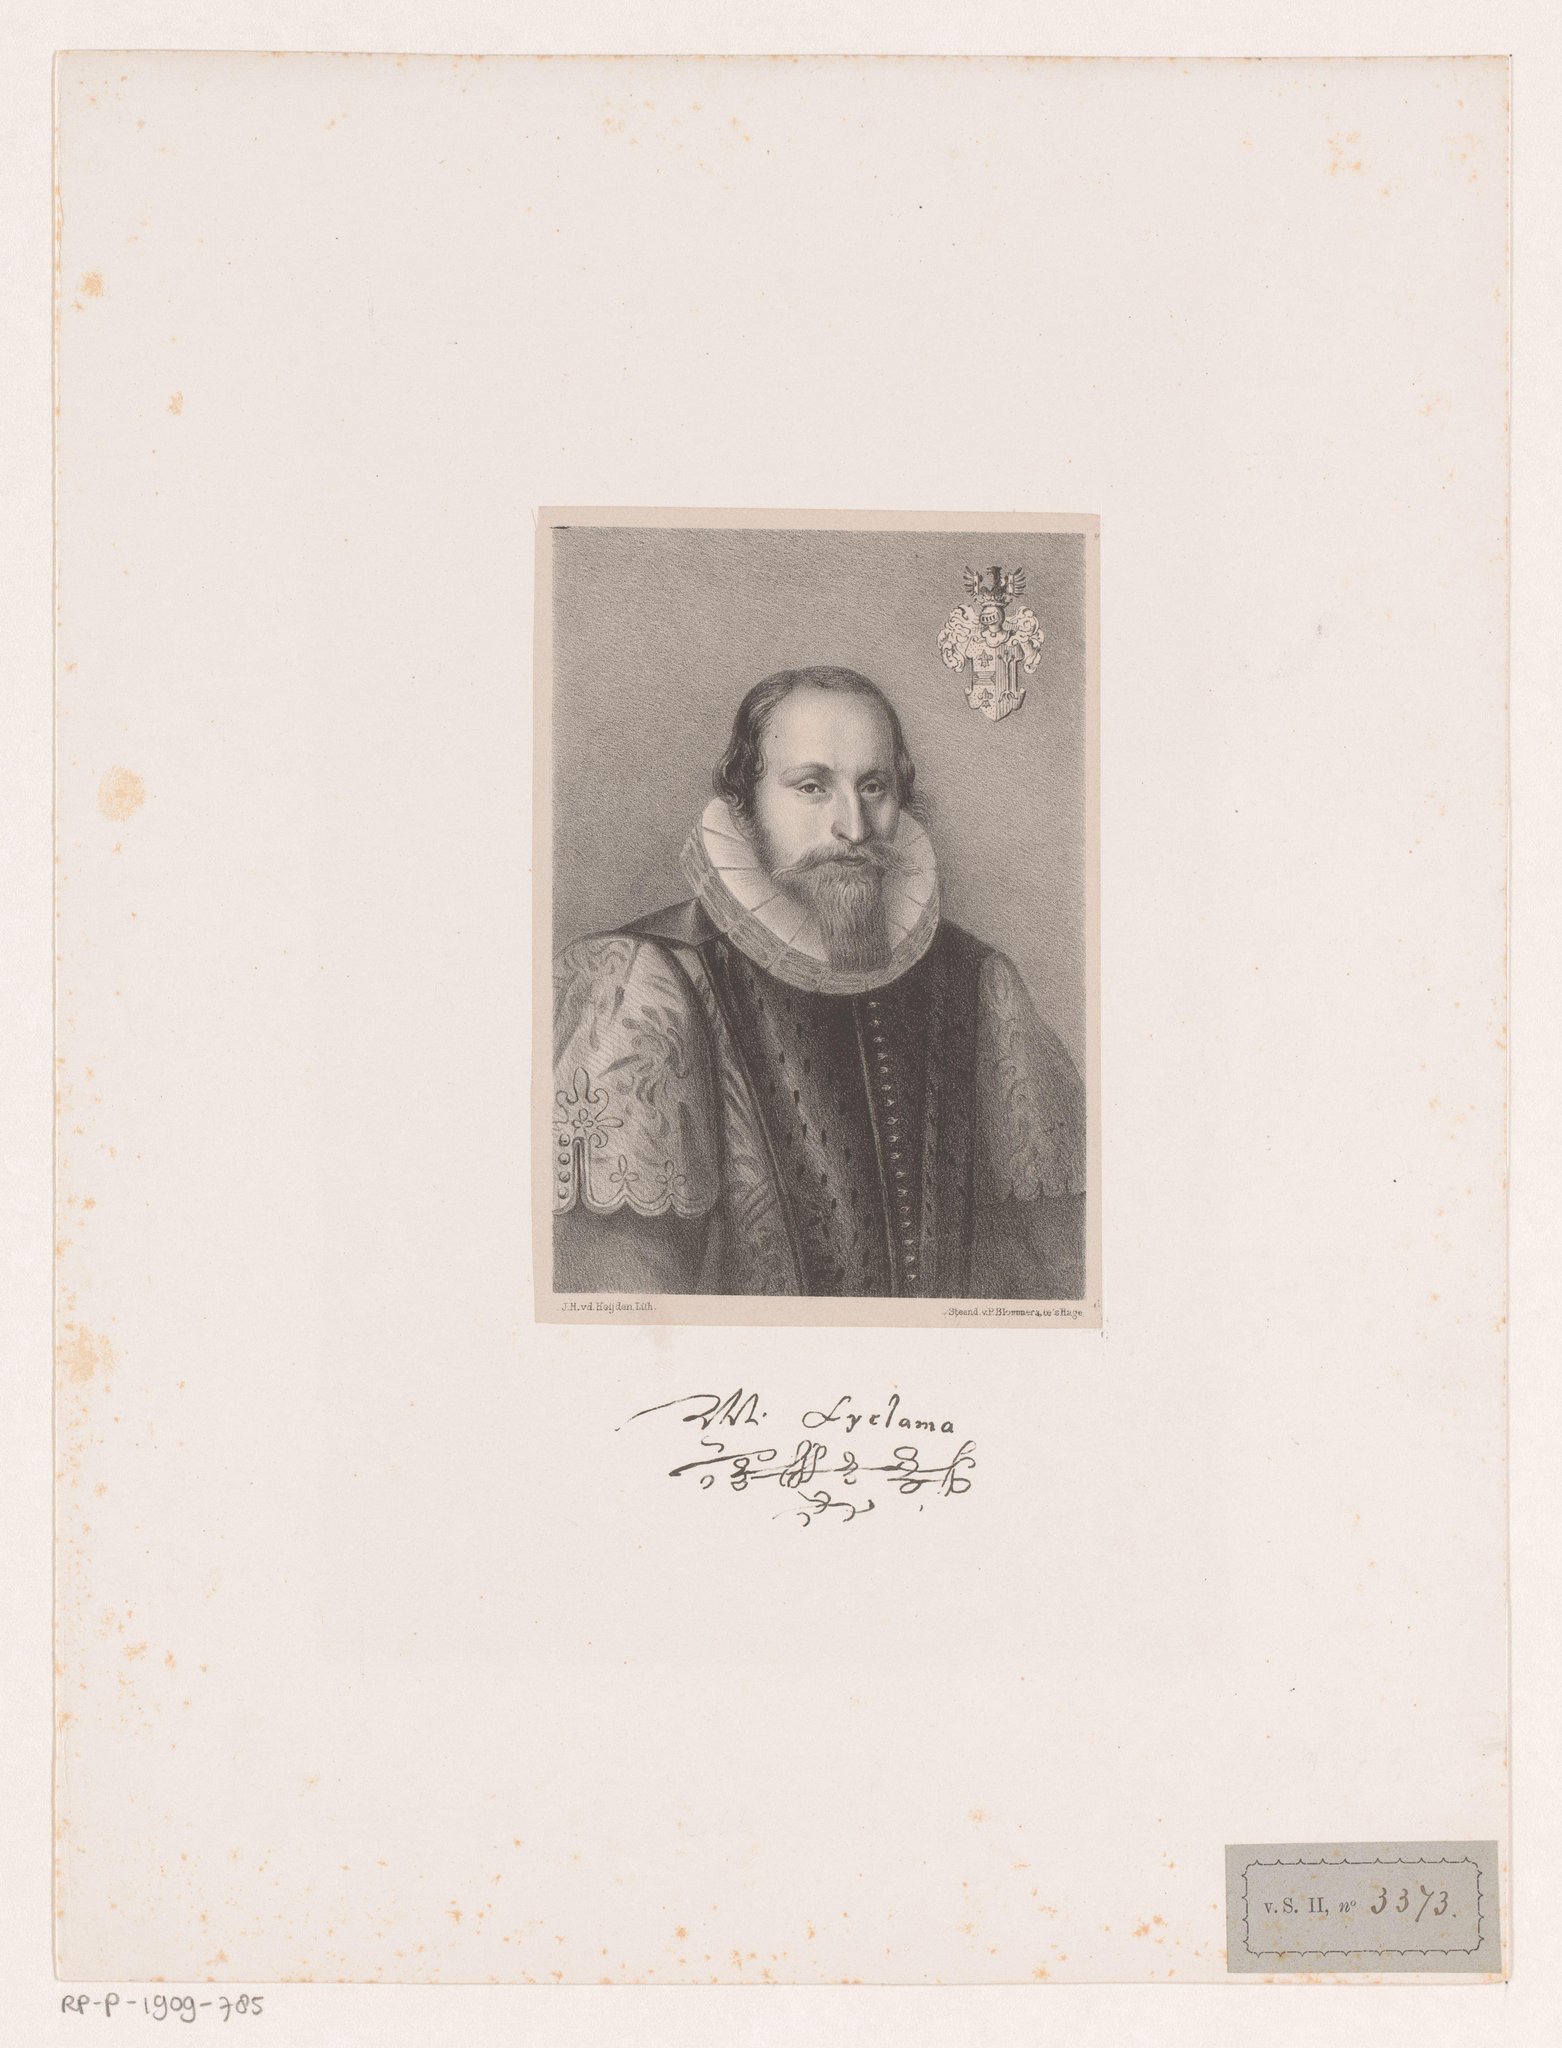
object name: print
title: Portret van Marcus Lyclama a Nyeholt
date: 1842-1887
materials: paper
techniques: lithograph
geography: the hague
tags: neck-gear ~ clothing (with name), historical persons (+ (full) bust portrait), armorial bearing, heraldry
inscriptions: collector's mark: Lugt 2228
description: De geportretteerde heeft een baard, sik, snor en plooikraag. Rechtsboven een familiewapen. Onder het portret zijn signatuur.